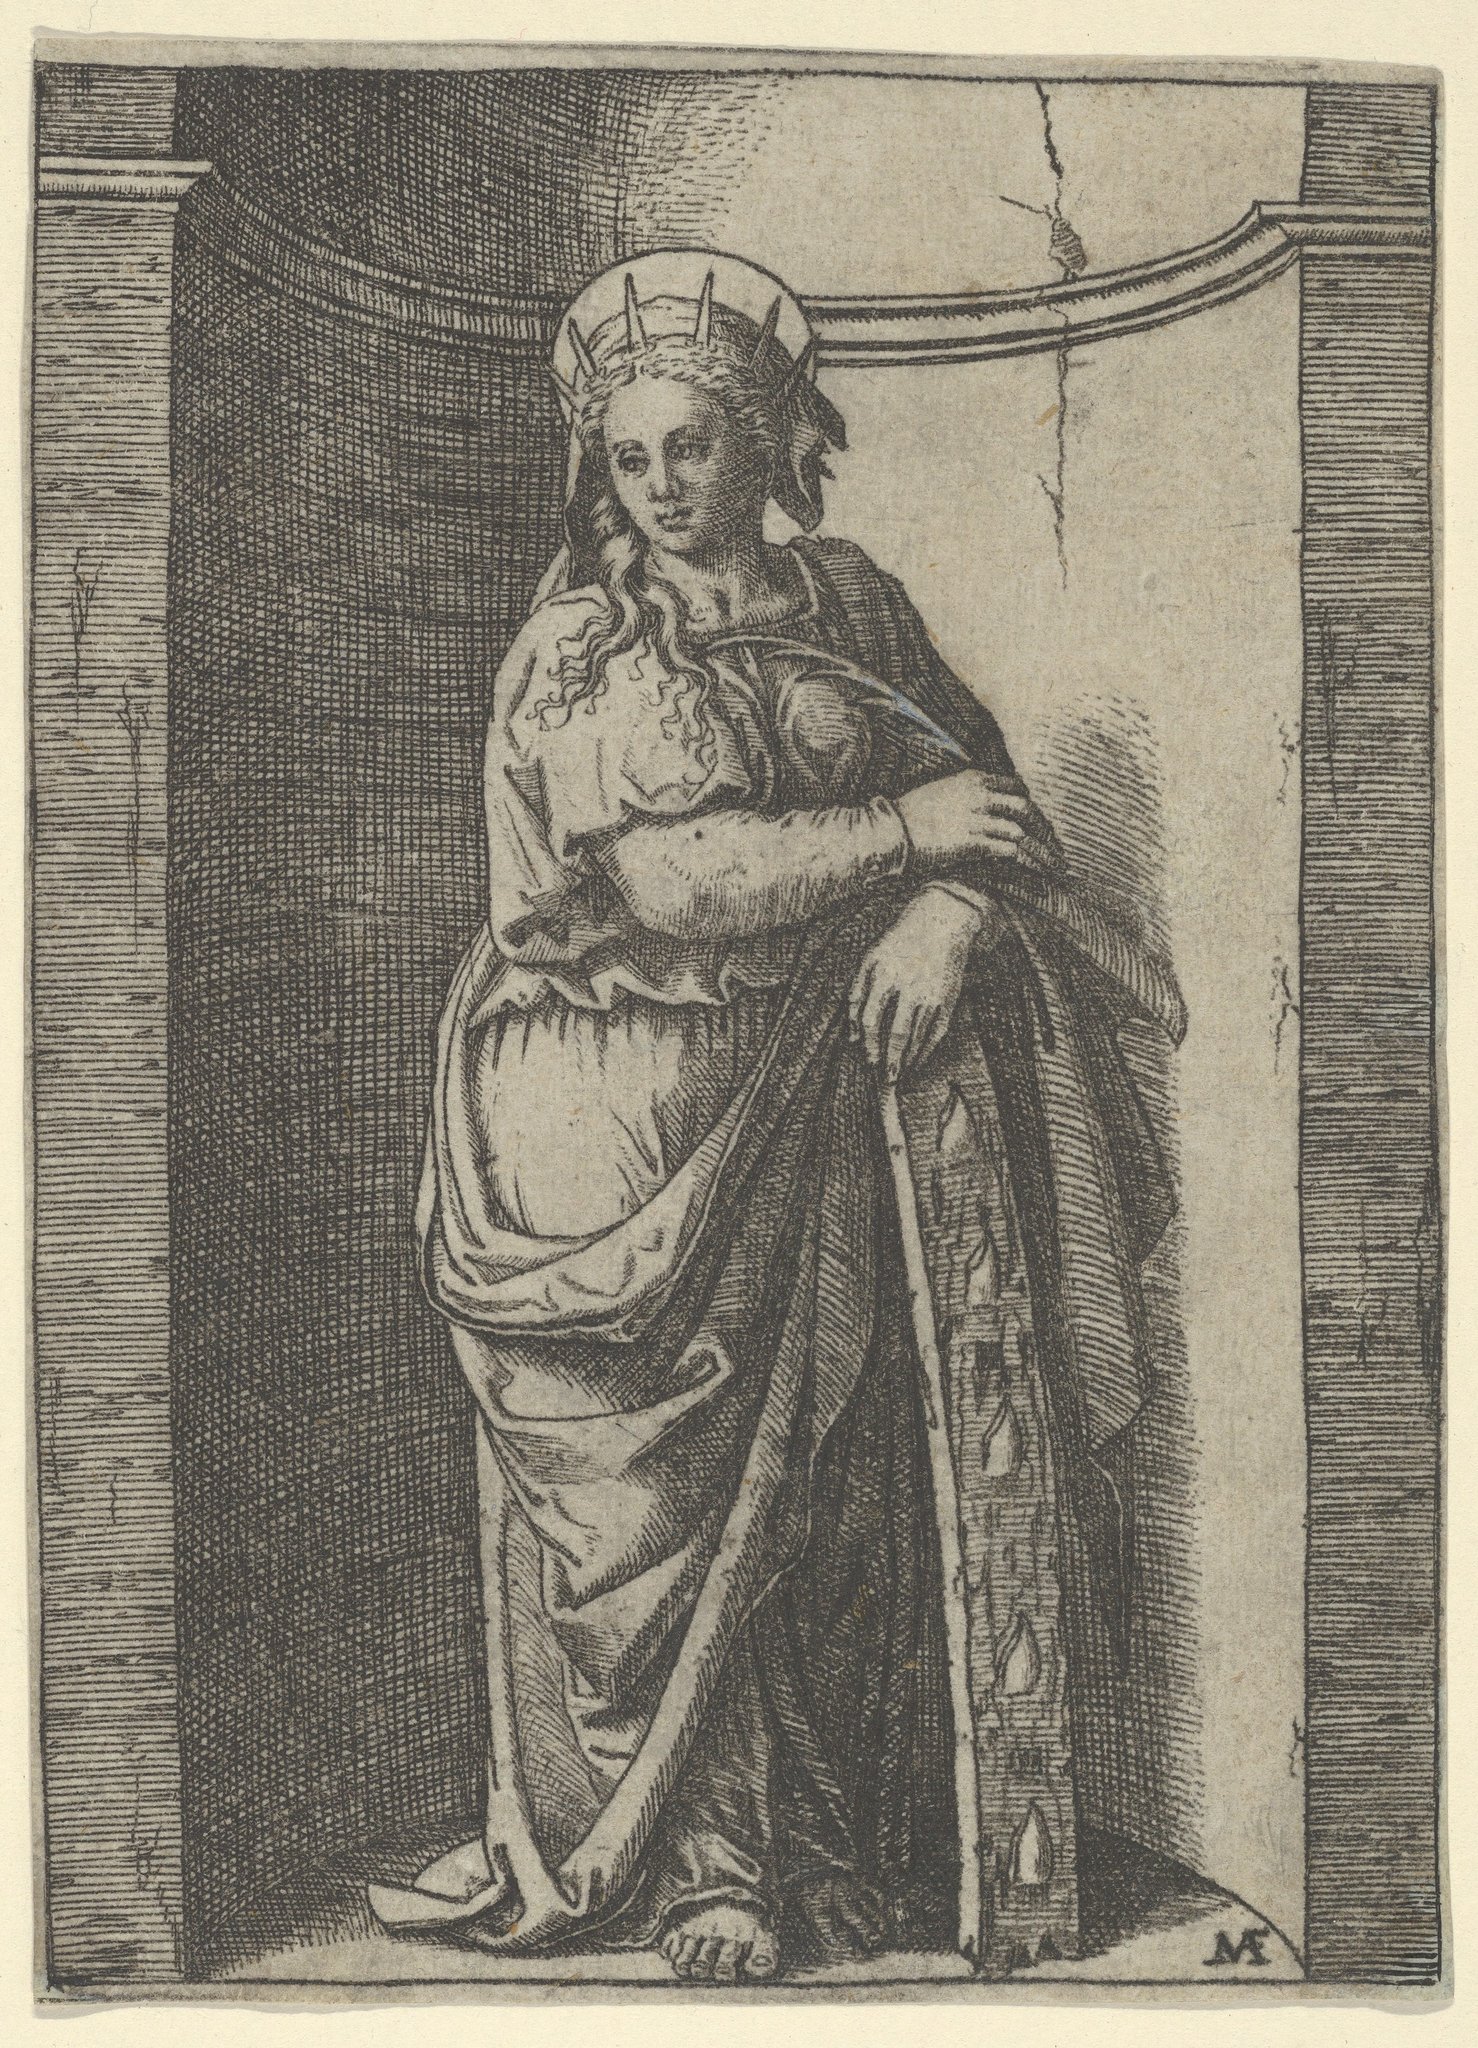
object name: print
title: Saint Catherine standing in a niche, resting on a wheel, her instrument of torture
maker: marcantonio raimondi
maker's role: artist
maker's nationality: italian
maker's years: 1475-1534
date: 1500-1527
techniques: engraving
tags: saint catherine